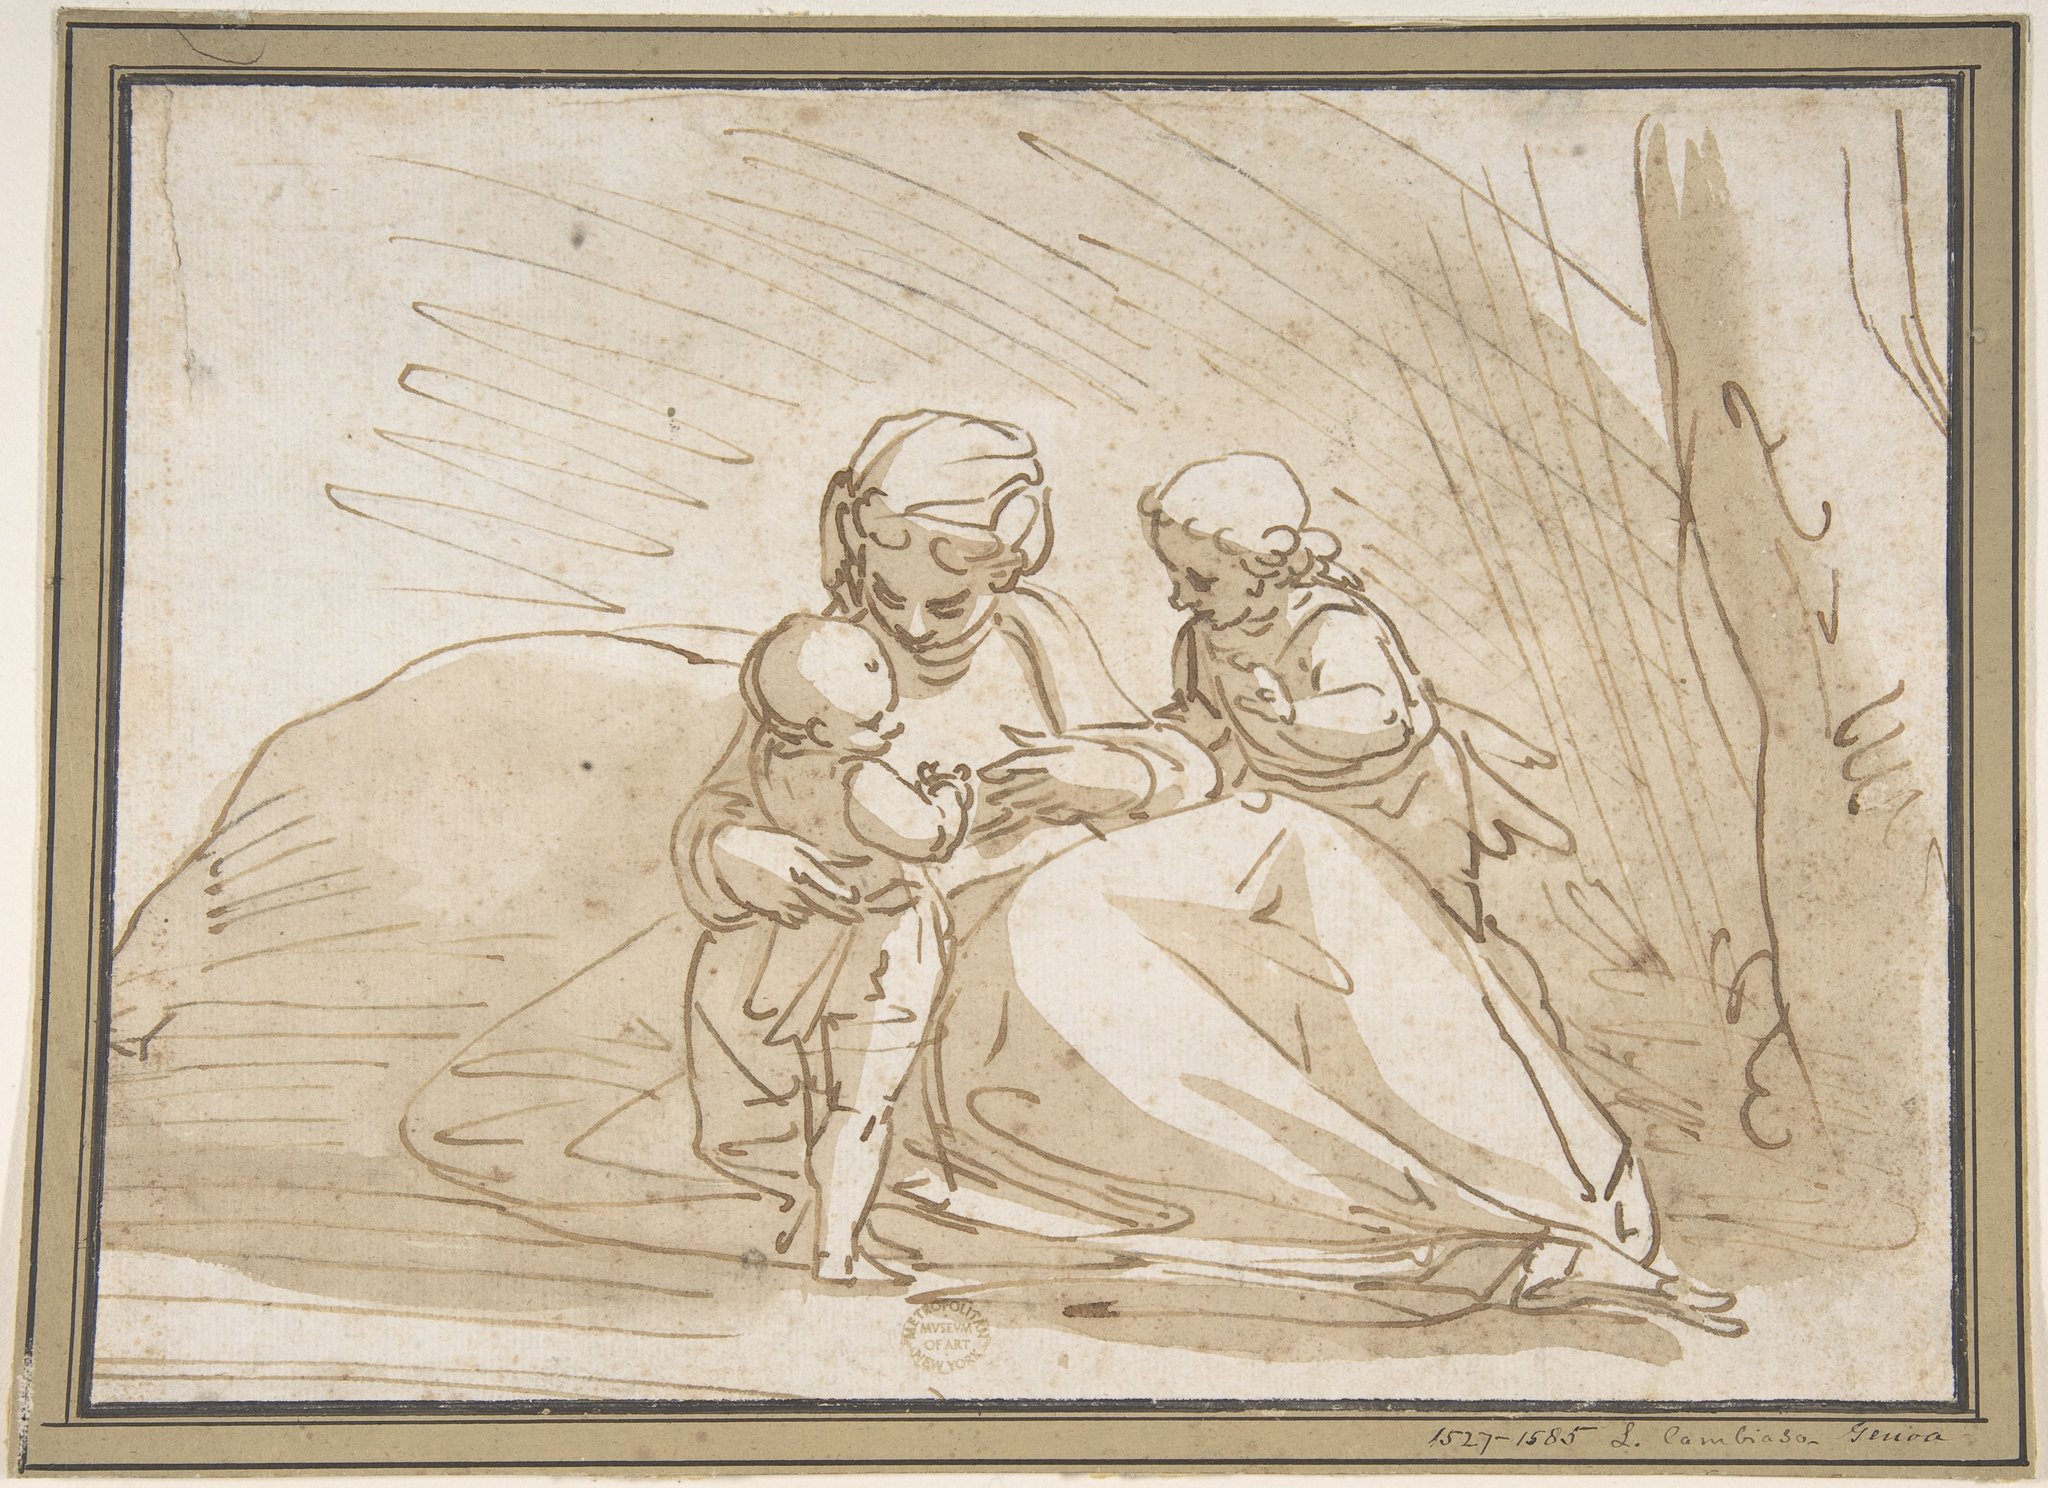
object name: drawing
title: Madonna and Child with the Infant Saint John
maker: luca cambiaso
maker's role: artist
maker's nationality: italian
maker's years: 1527-1585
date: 1527-1585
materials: ink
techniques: brush, pen, wash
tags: infants,madonna and child,saint john the baptist